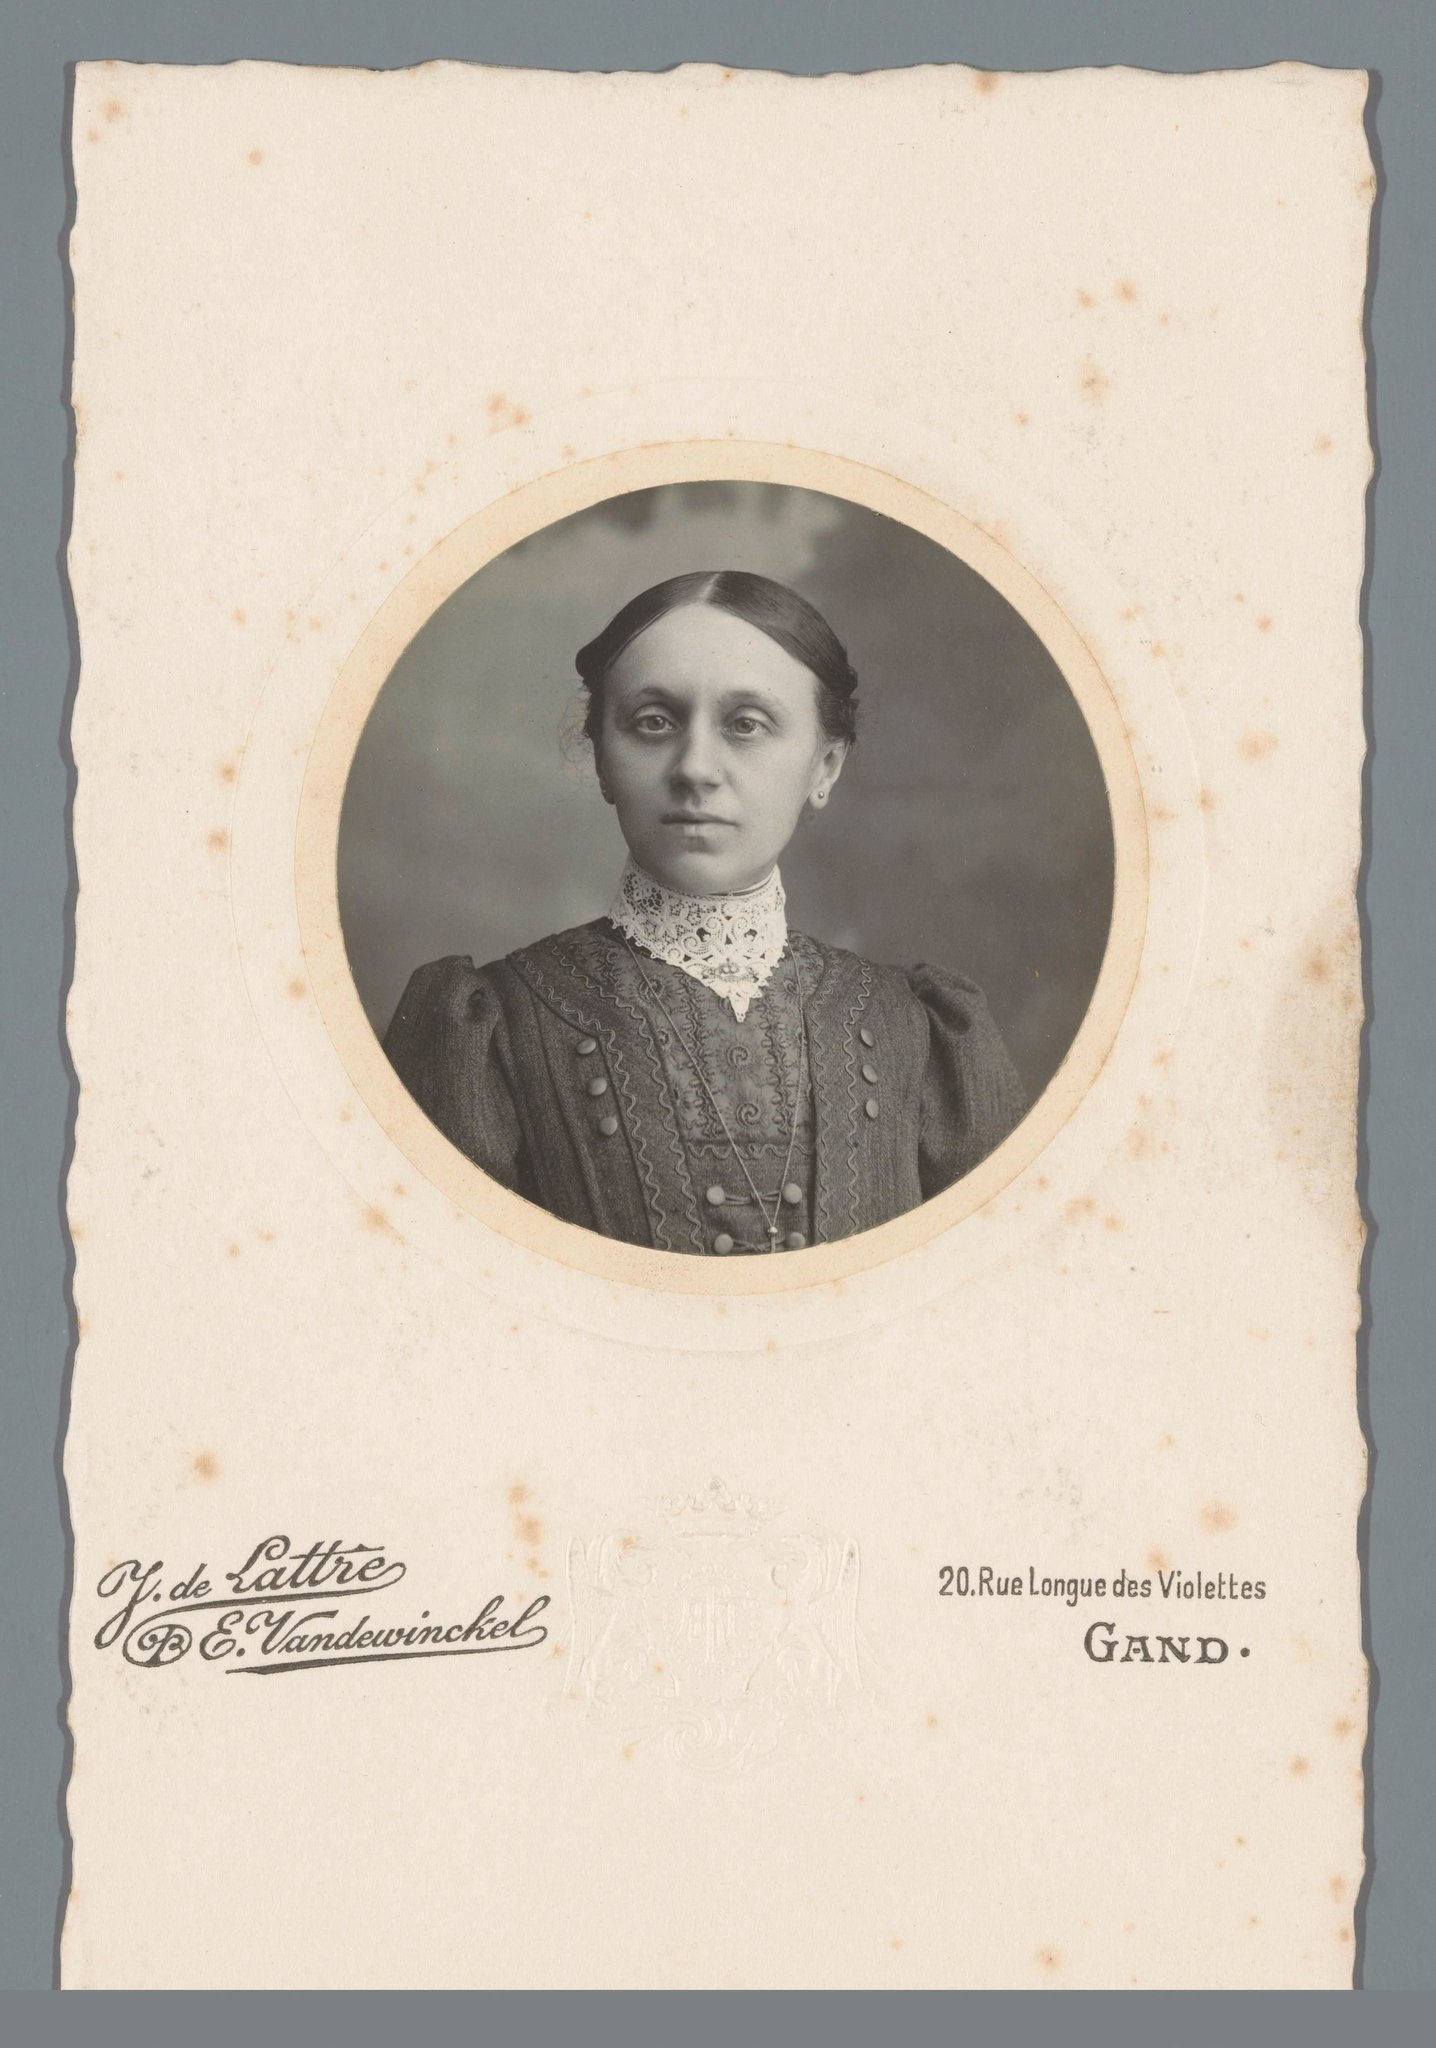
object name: cabinet photograph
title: Portret van een onbekende vrouw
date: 1890-1920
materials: cardboard, photographic support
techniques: gelatin silver print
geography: ghent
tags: adult woman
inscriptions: monogram: ‘AKT’